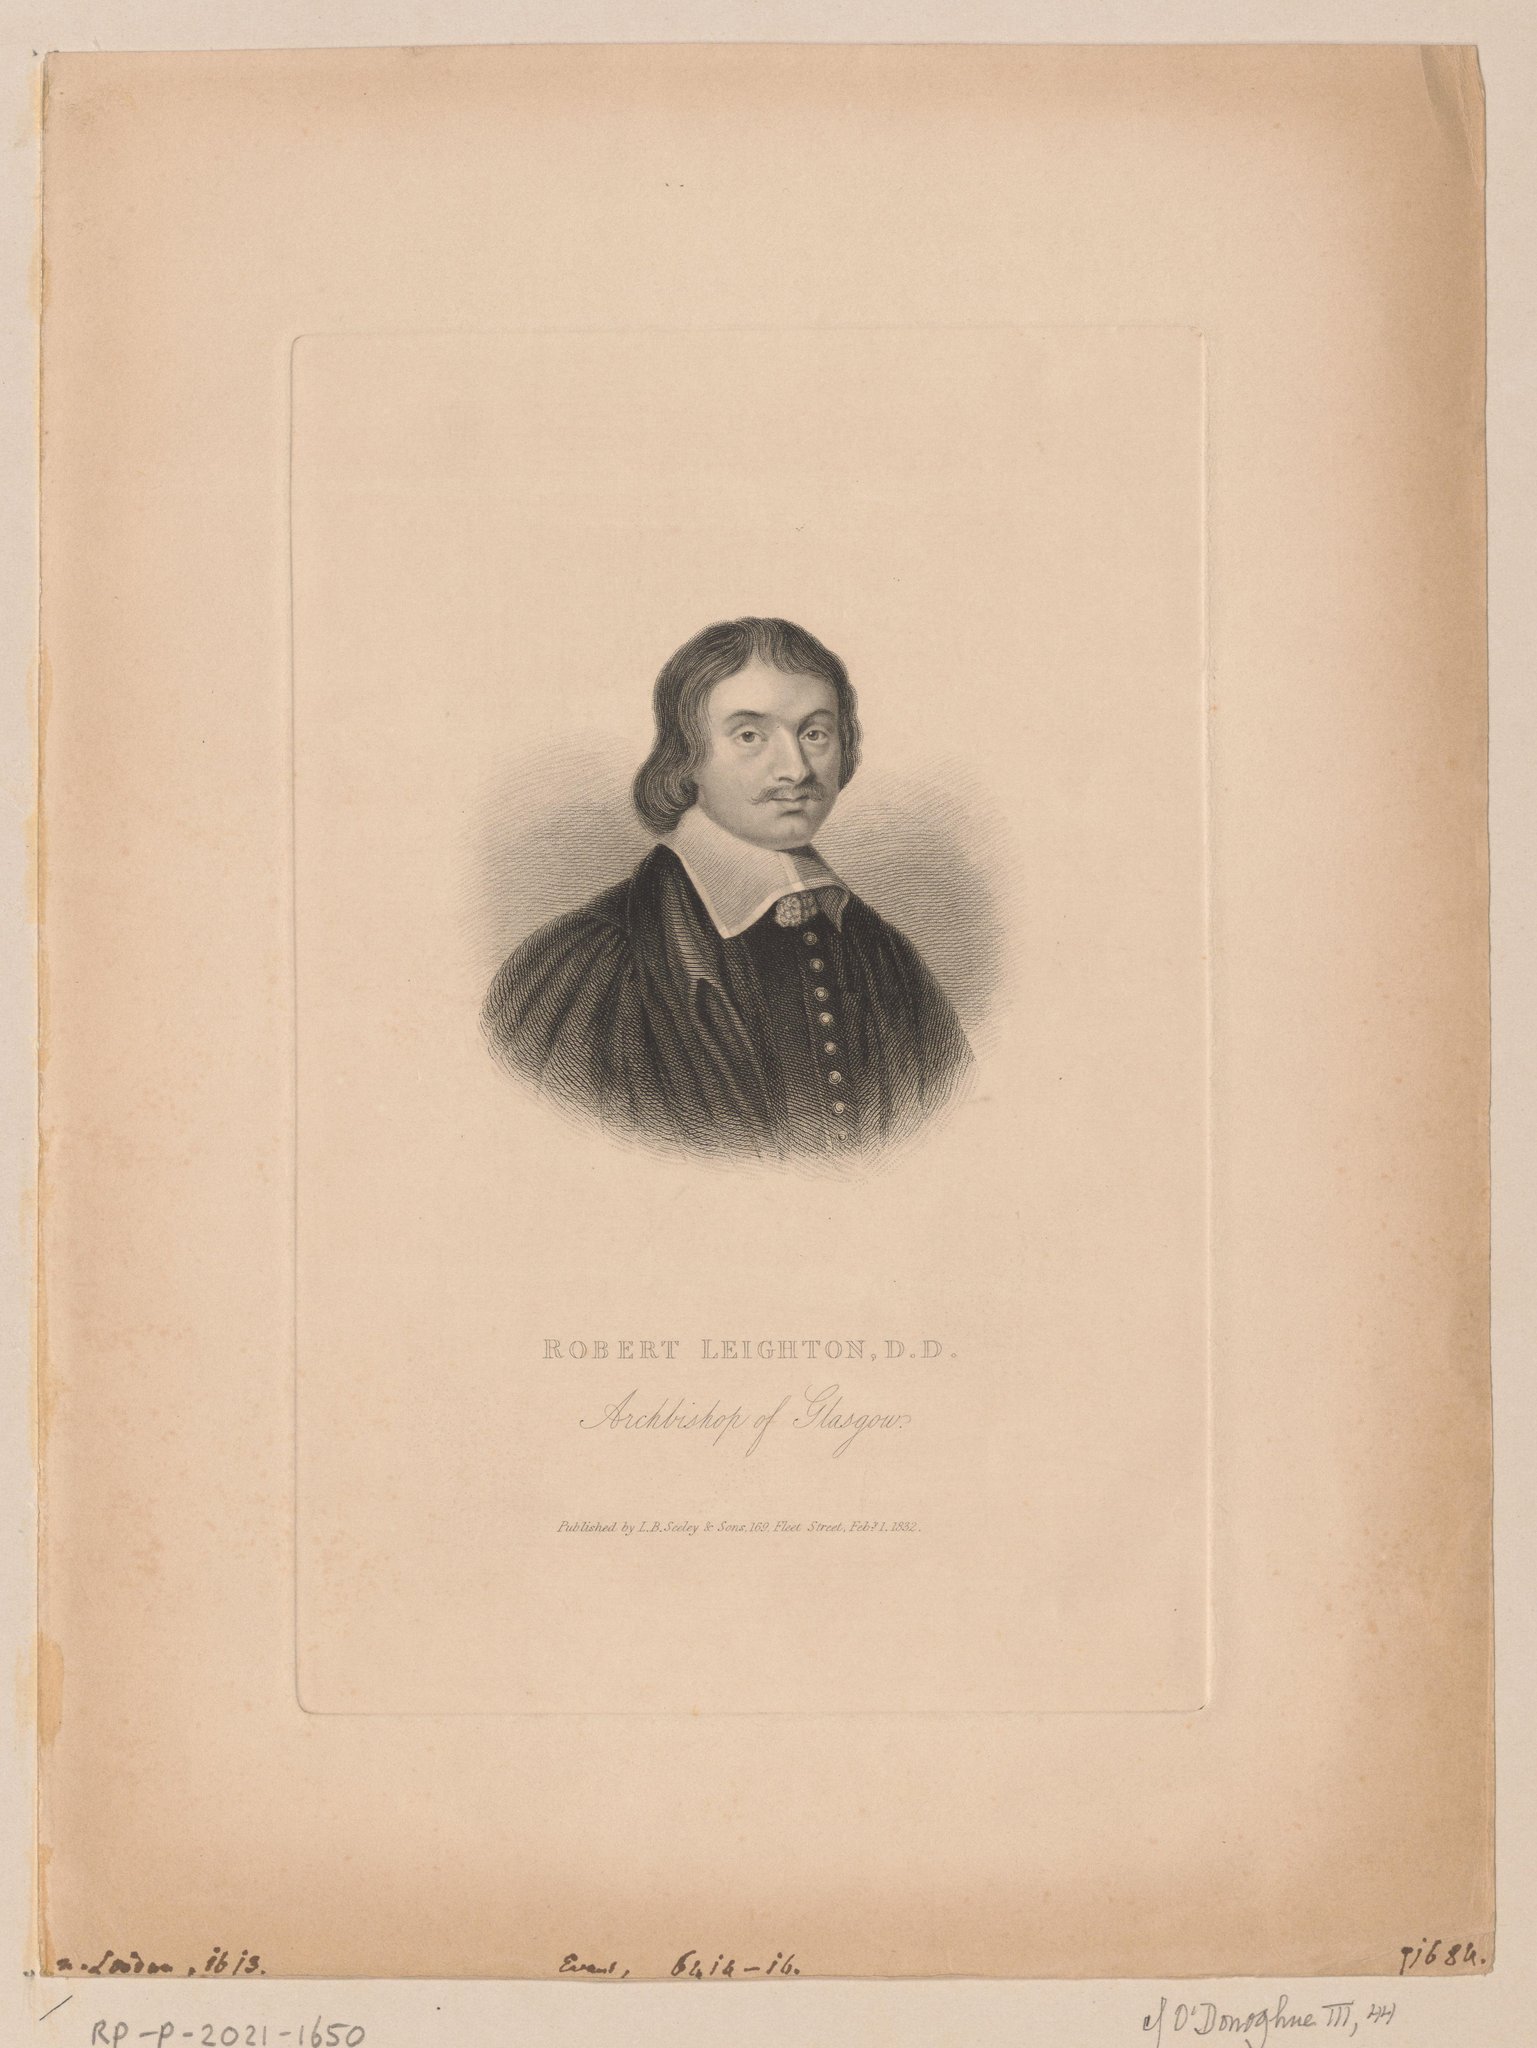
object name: print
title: Portret van Robert Leighton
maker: Anonymous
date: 1802-1832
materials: paper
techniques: etching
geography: london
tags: archbishop, bishop, etc. (roman catholic), historical persons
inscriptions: inscription: ‘n. London, 1613 Evans 6414-16. +1684’